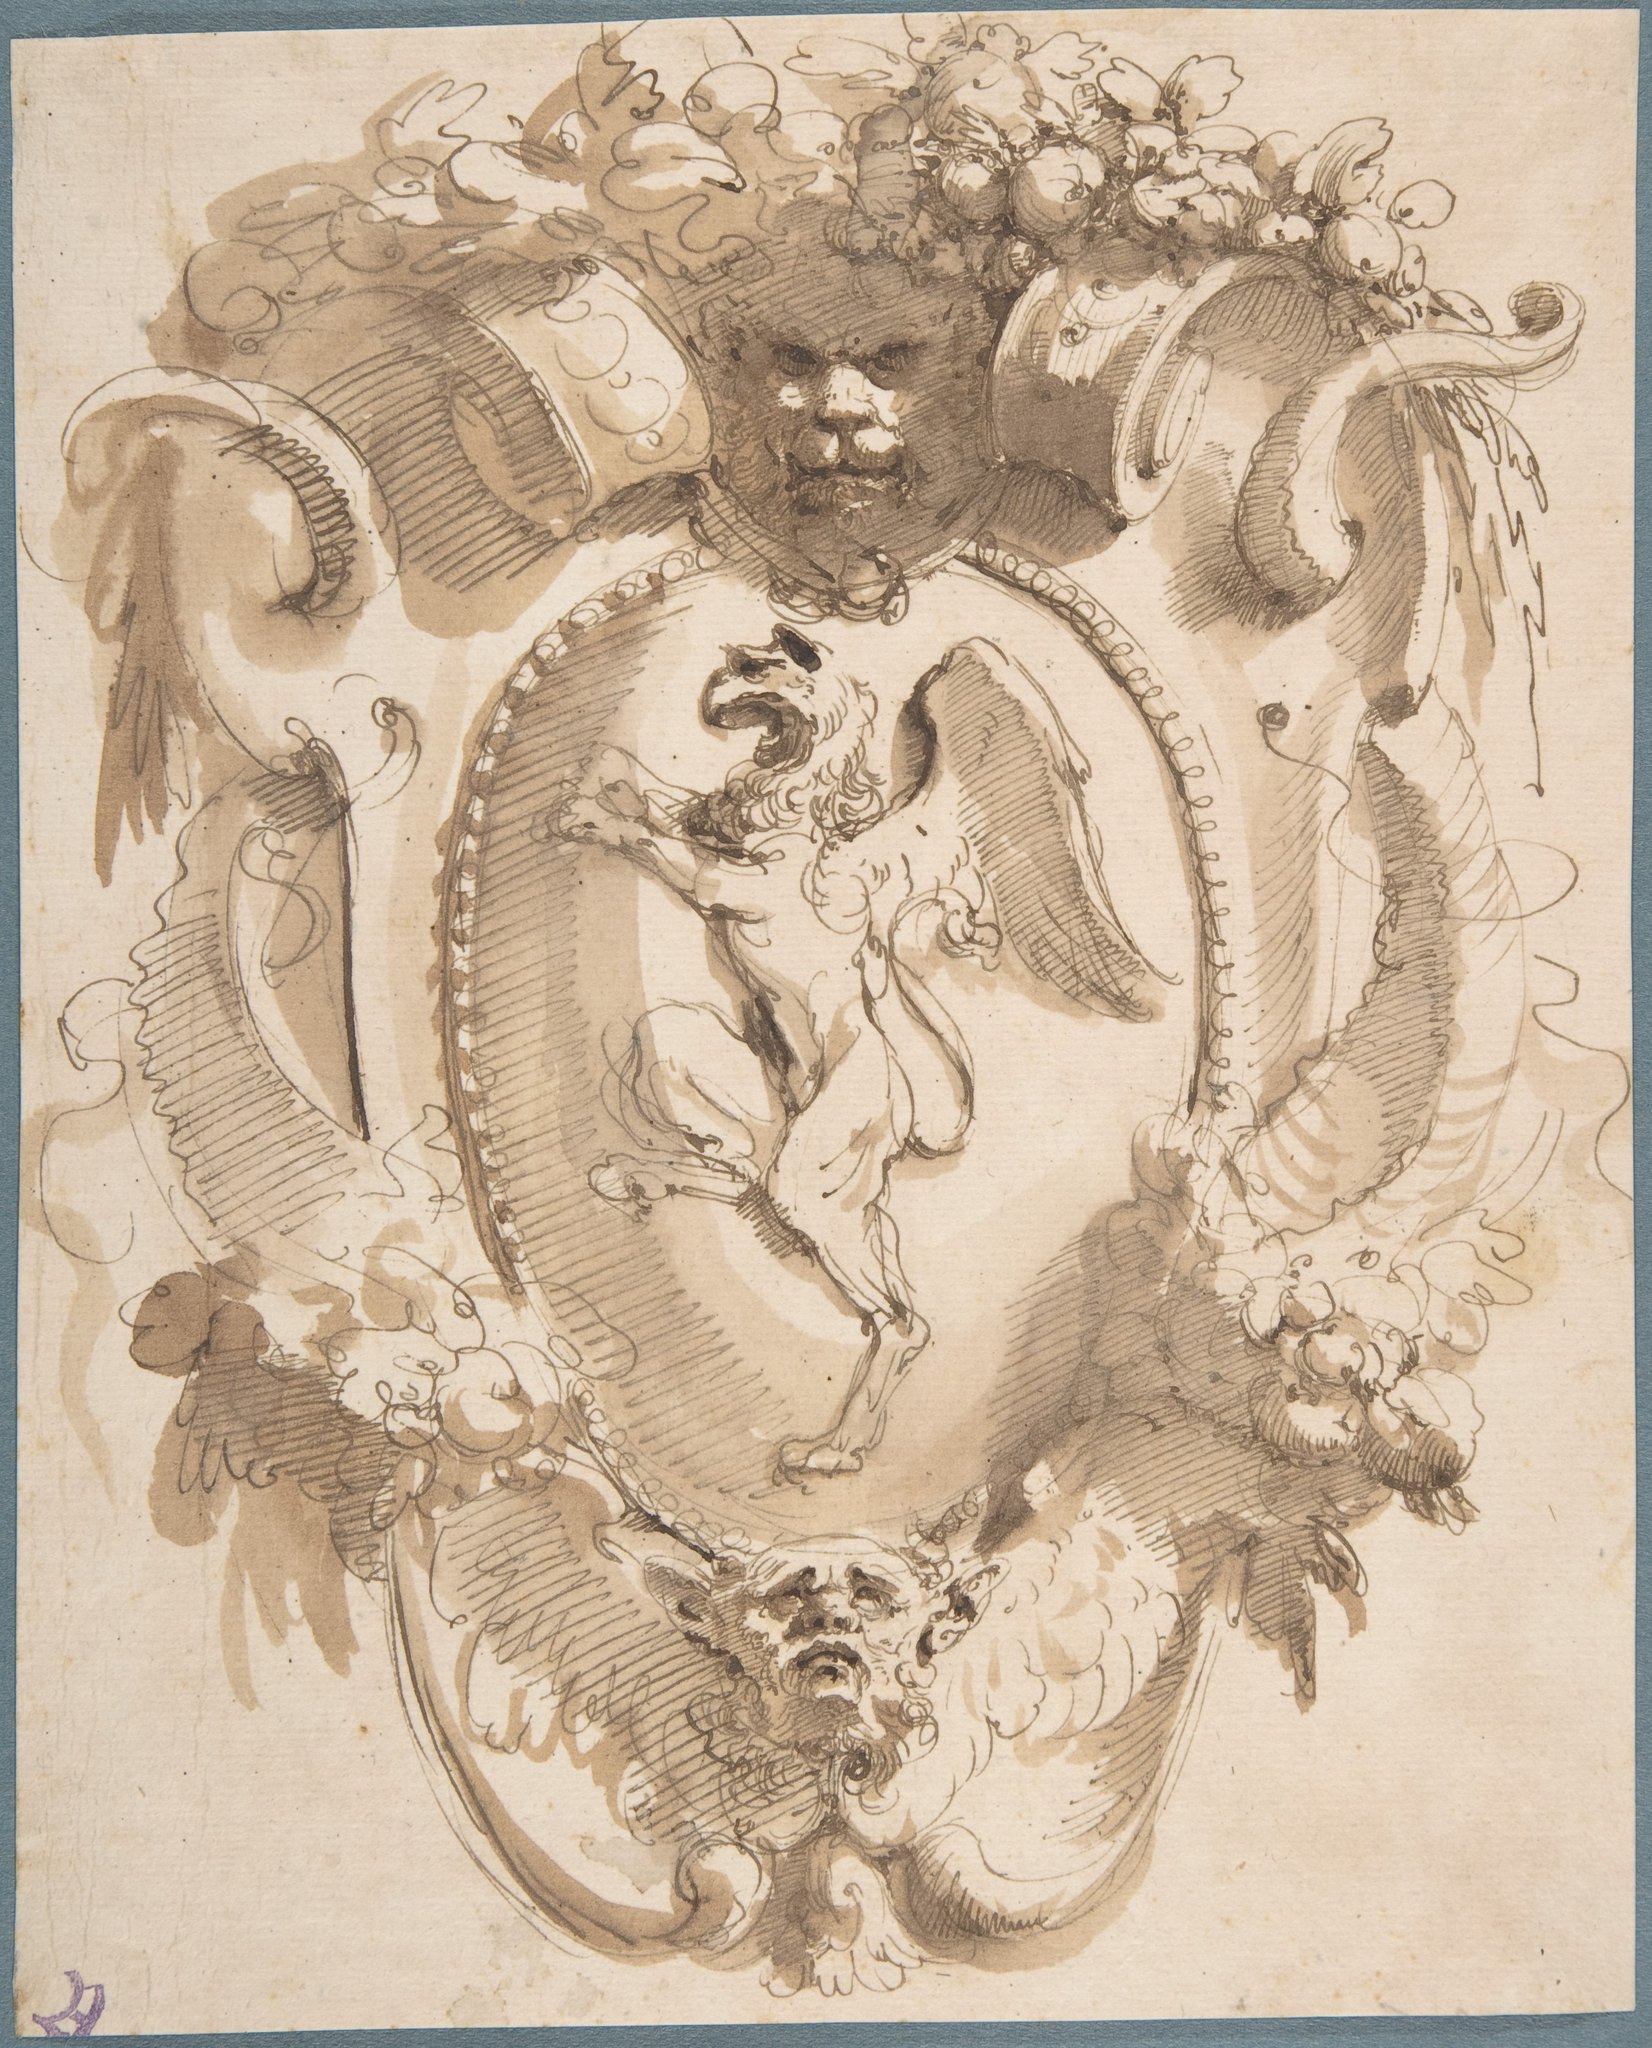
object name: drawing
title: Design for a Cartouche with a Coat of Arms containing a Griffin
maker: carlo bianconi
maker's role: artist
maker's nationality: italian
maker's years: 1732-1802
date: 1752-1802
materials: ink, drawing material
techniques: brush, pen, wash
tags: cartouches,griffins,coat of arms